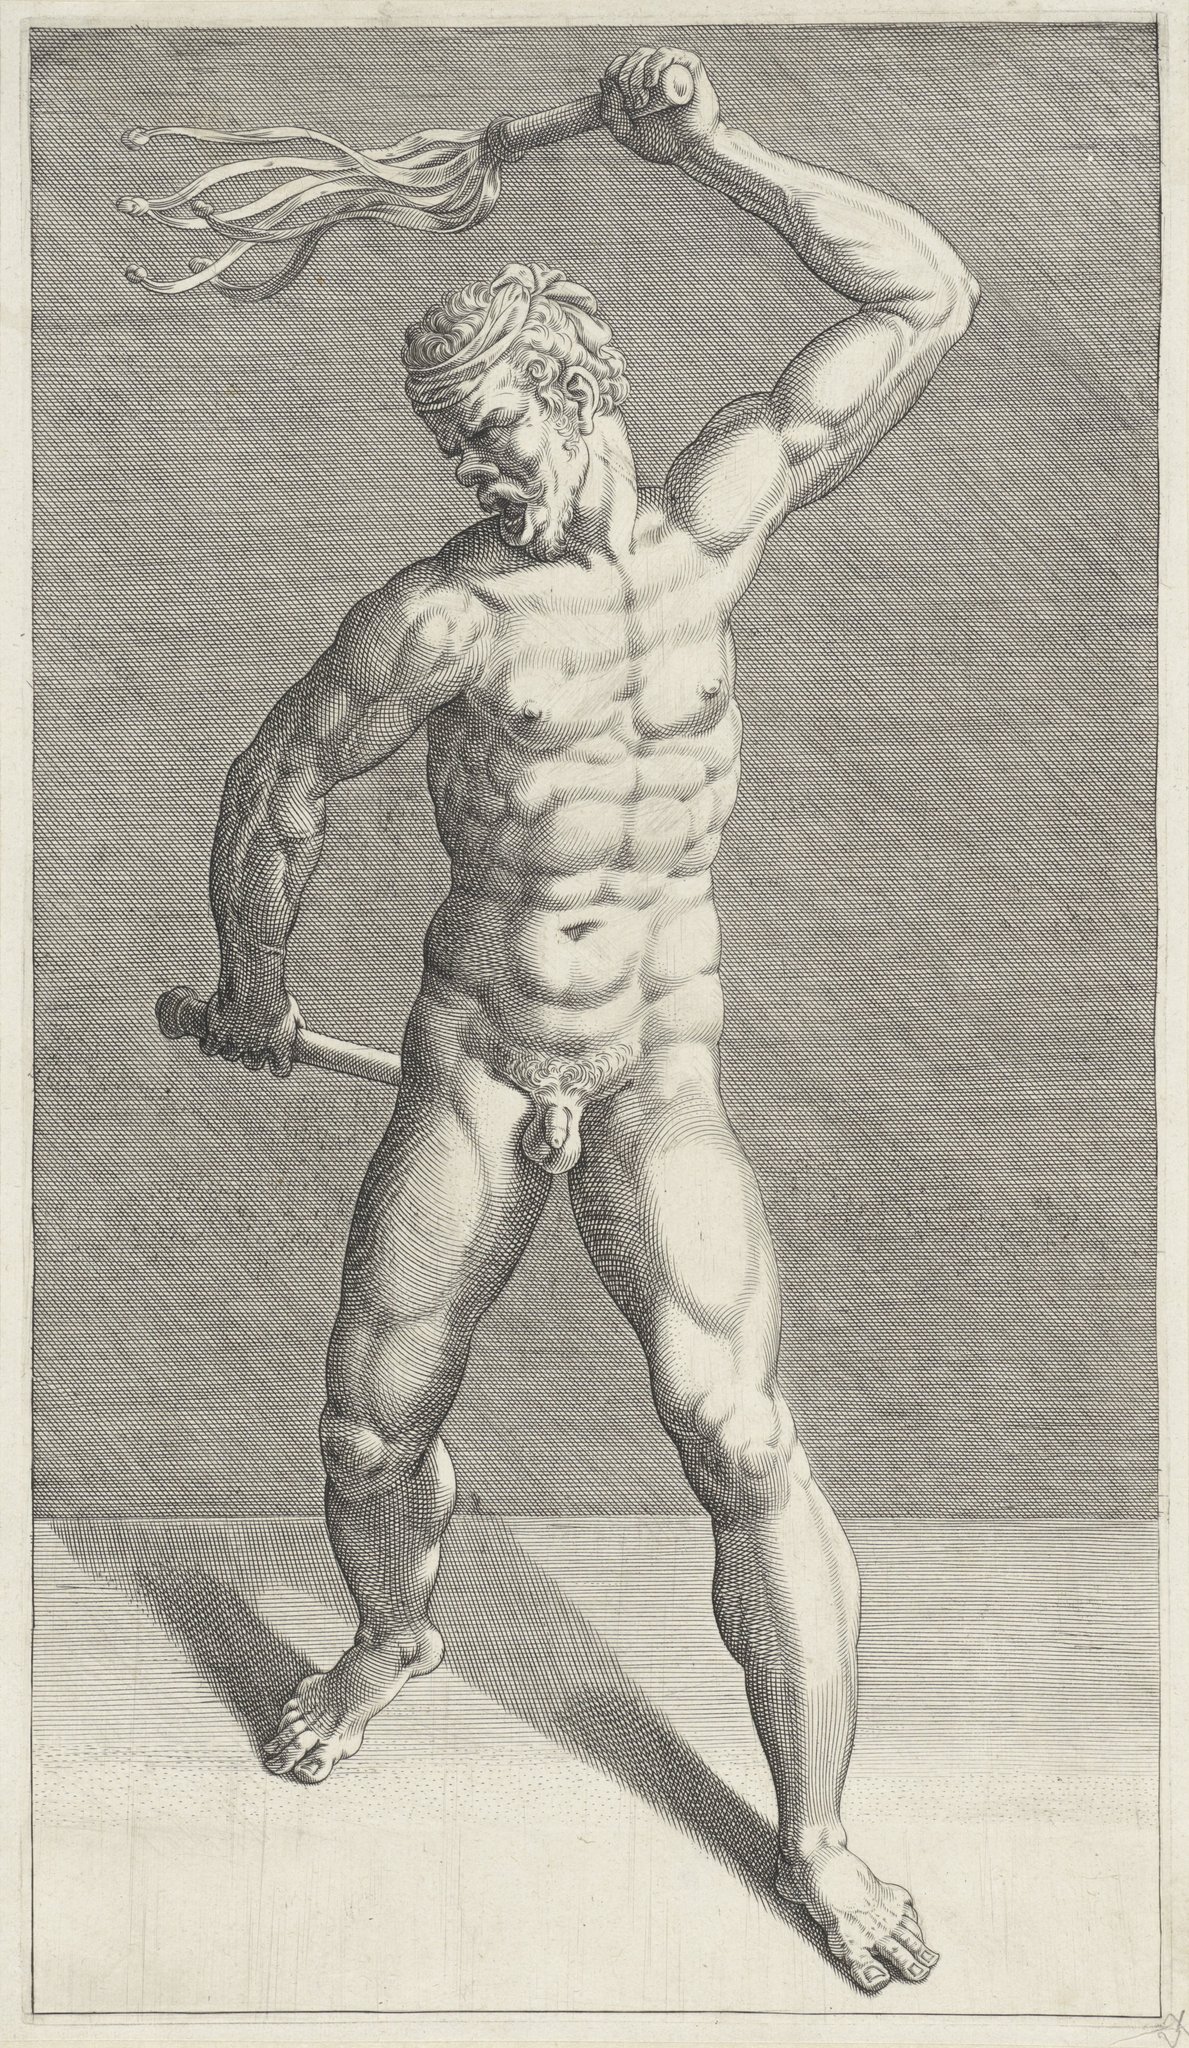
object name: print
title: Geseling van Christus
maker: Anonymous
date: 1550-1625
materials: paper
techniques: engraving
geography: low countries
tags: flagellation by soldiers, christ usually tied to a column (matthew 27:26; mark 15:15; john 19:1)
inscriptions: collector's mark: Lugt 2228, collector's mark: Lugt 2760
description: Een naakte man, van voren gezien, heeft twee gesels vast. Zijn linkerarm houdt hij in de lucht.